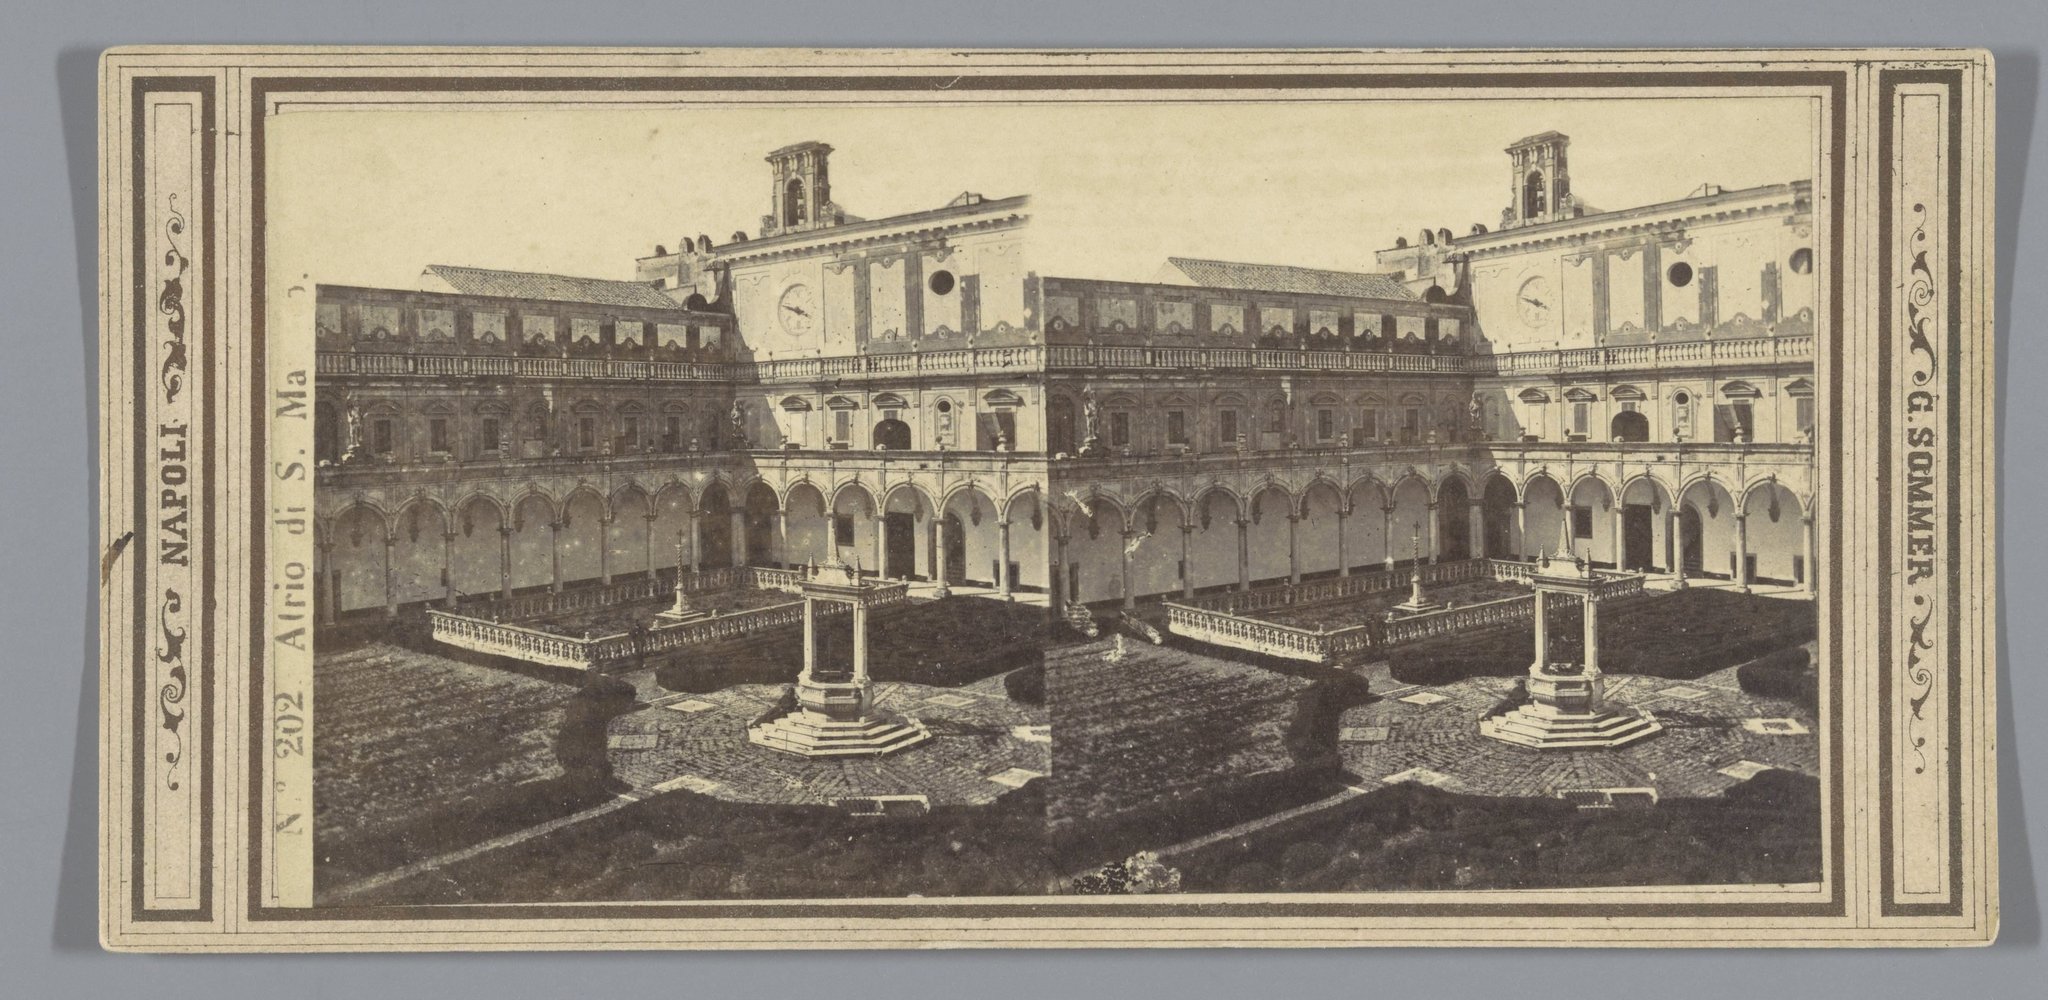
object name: stereograph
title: Napoli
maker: giorgio sommer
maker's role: fotograaf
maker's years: 1834-1914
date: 1860-1880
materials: cardboard, photographic support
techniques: albumen print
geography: napoli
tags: courtyard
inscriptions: number: ‘K 25.’, number: ‘No 202’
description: Het atrium van het karthuizerklooster San Martino in Napels.